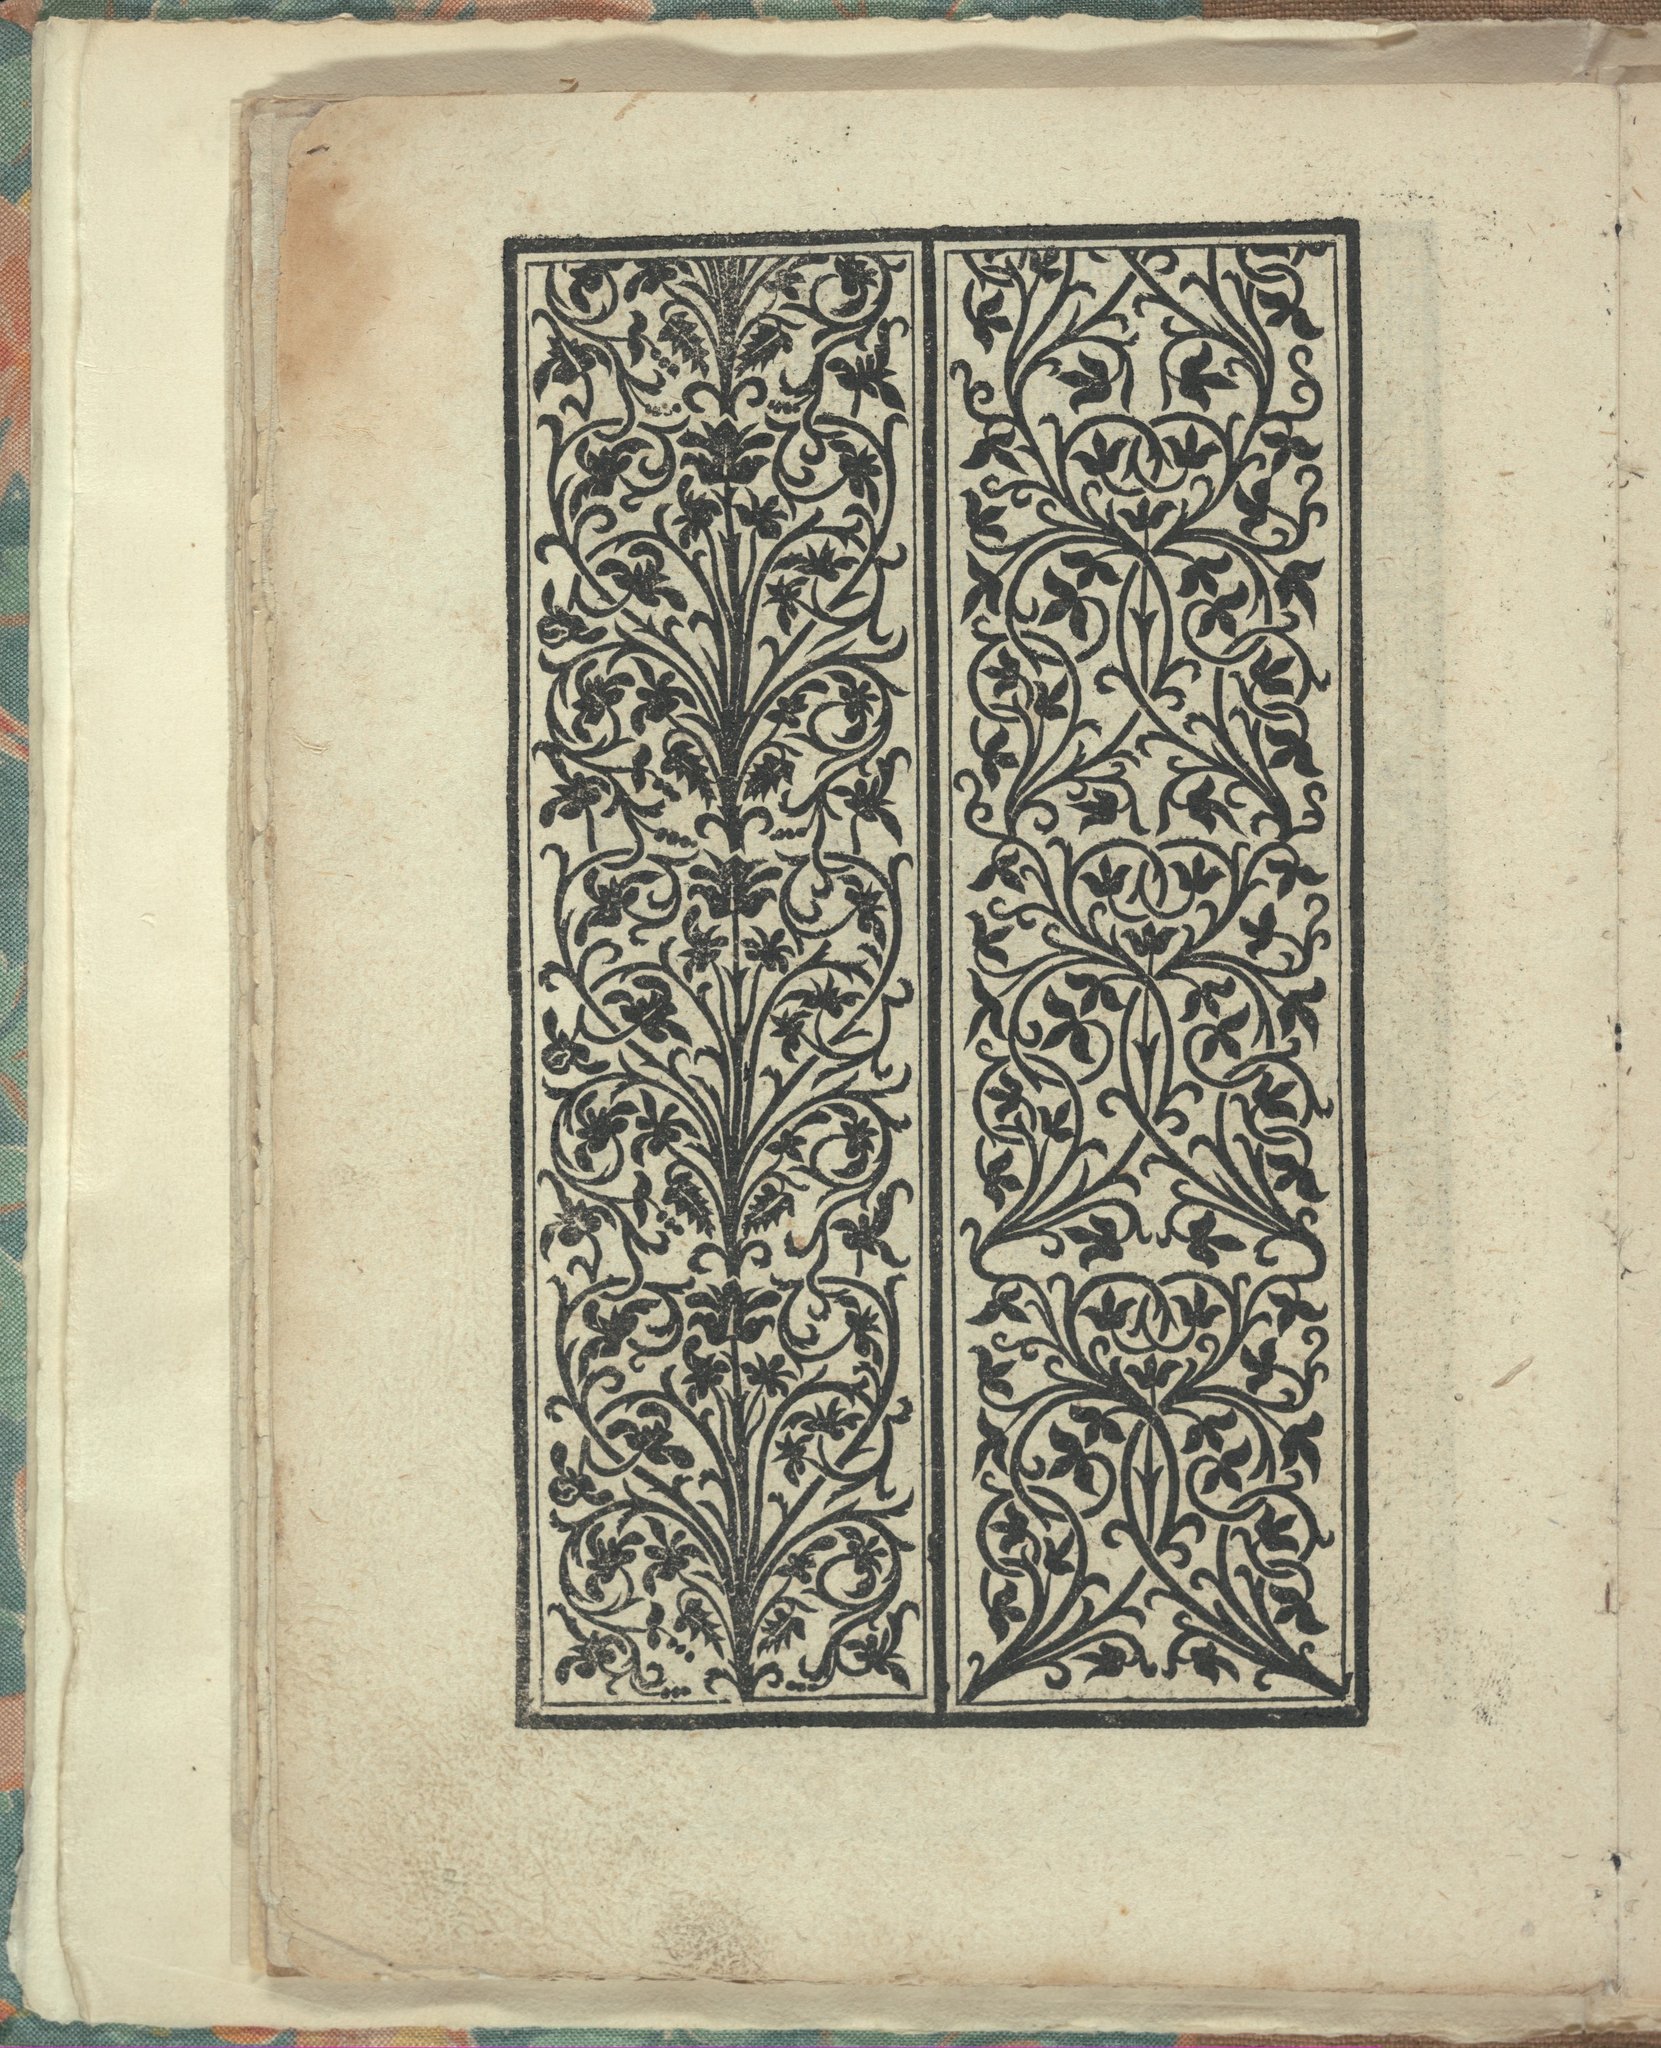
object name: book print ornament architecture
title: Opera Nova Universali intitulata Corona di racammi, page 18 (verso)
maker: giovanni andrea vavassore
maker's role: publisher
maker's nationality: italian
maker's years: 1530-1573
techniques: woodcut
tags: vines